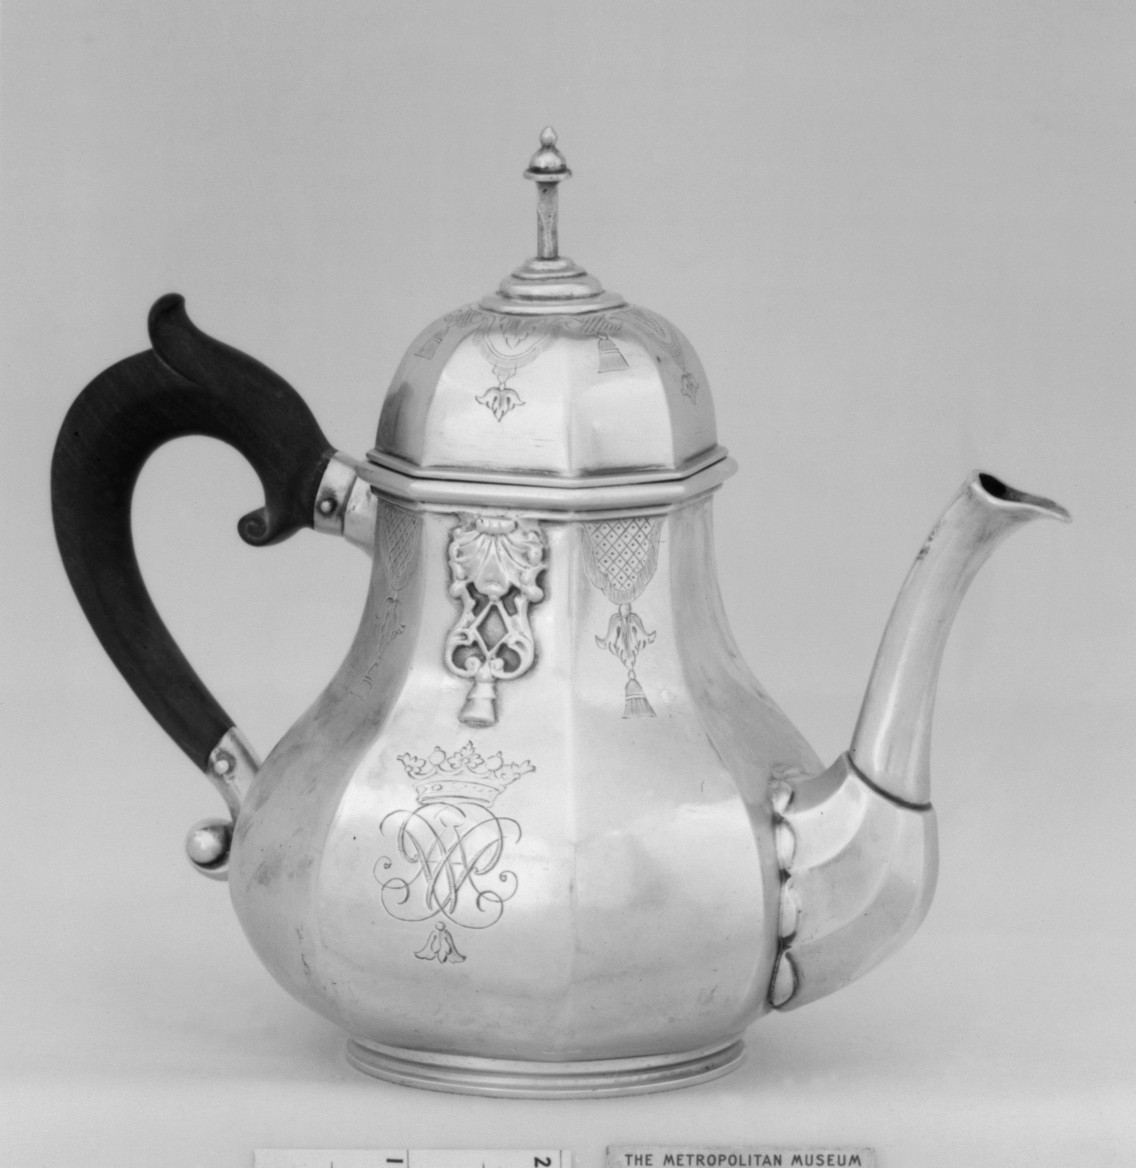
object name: teapot with cover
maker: harmanus nieuwenhuys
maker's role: maker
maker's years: 1736-1763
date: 1743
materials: silver, wood